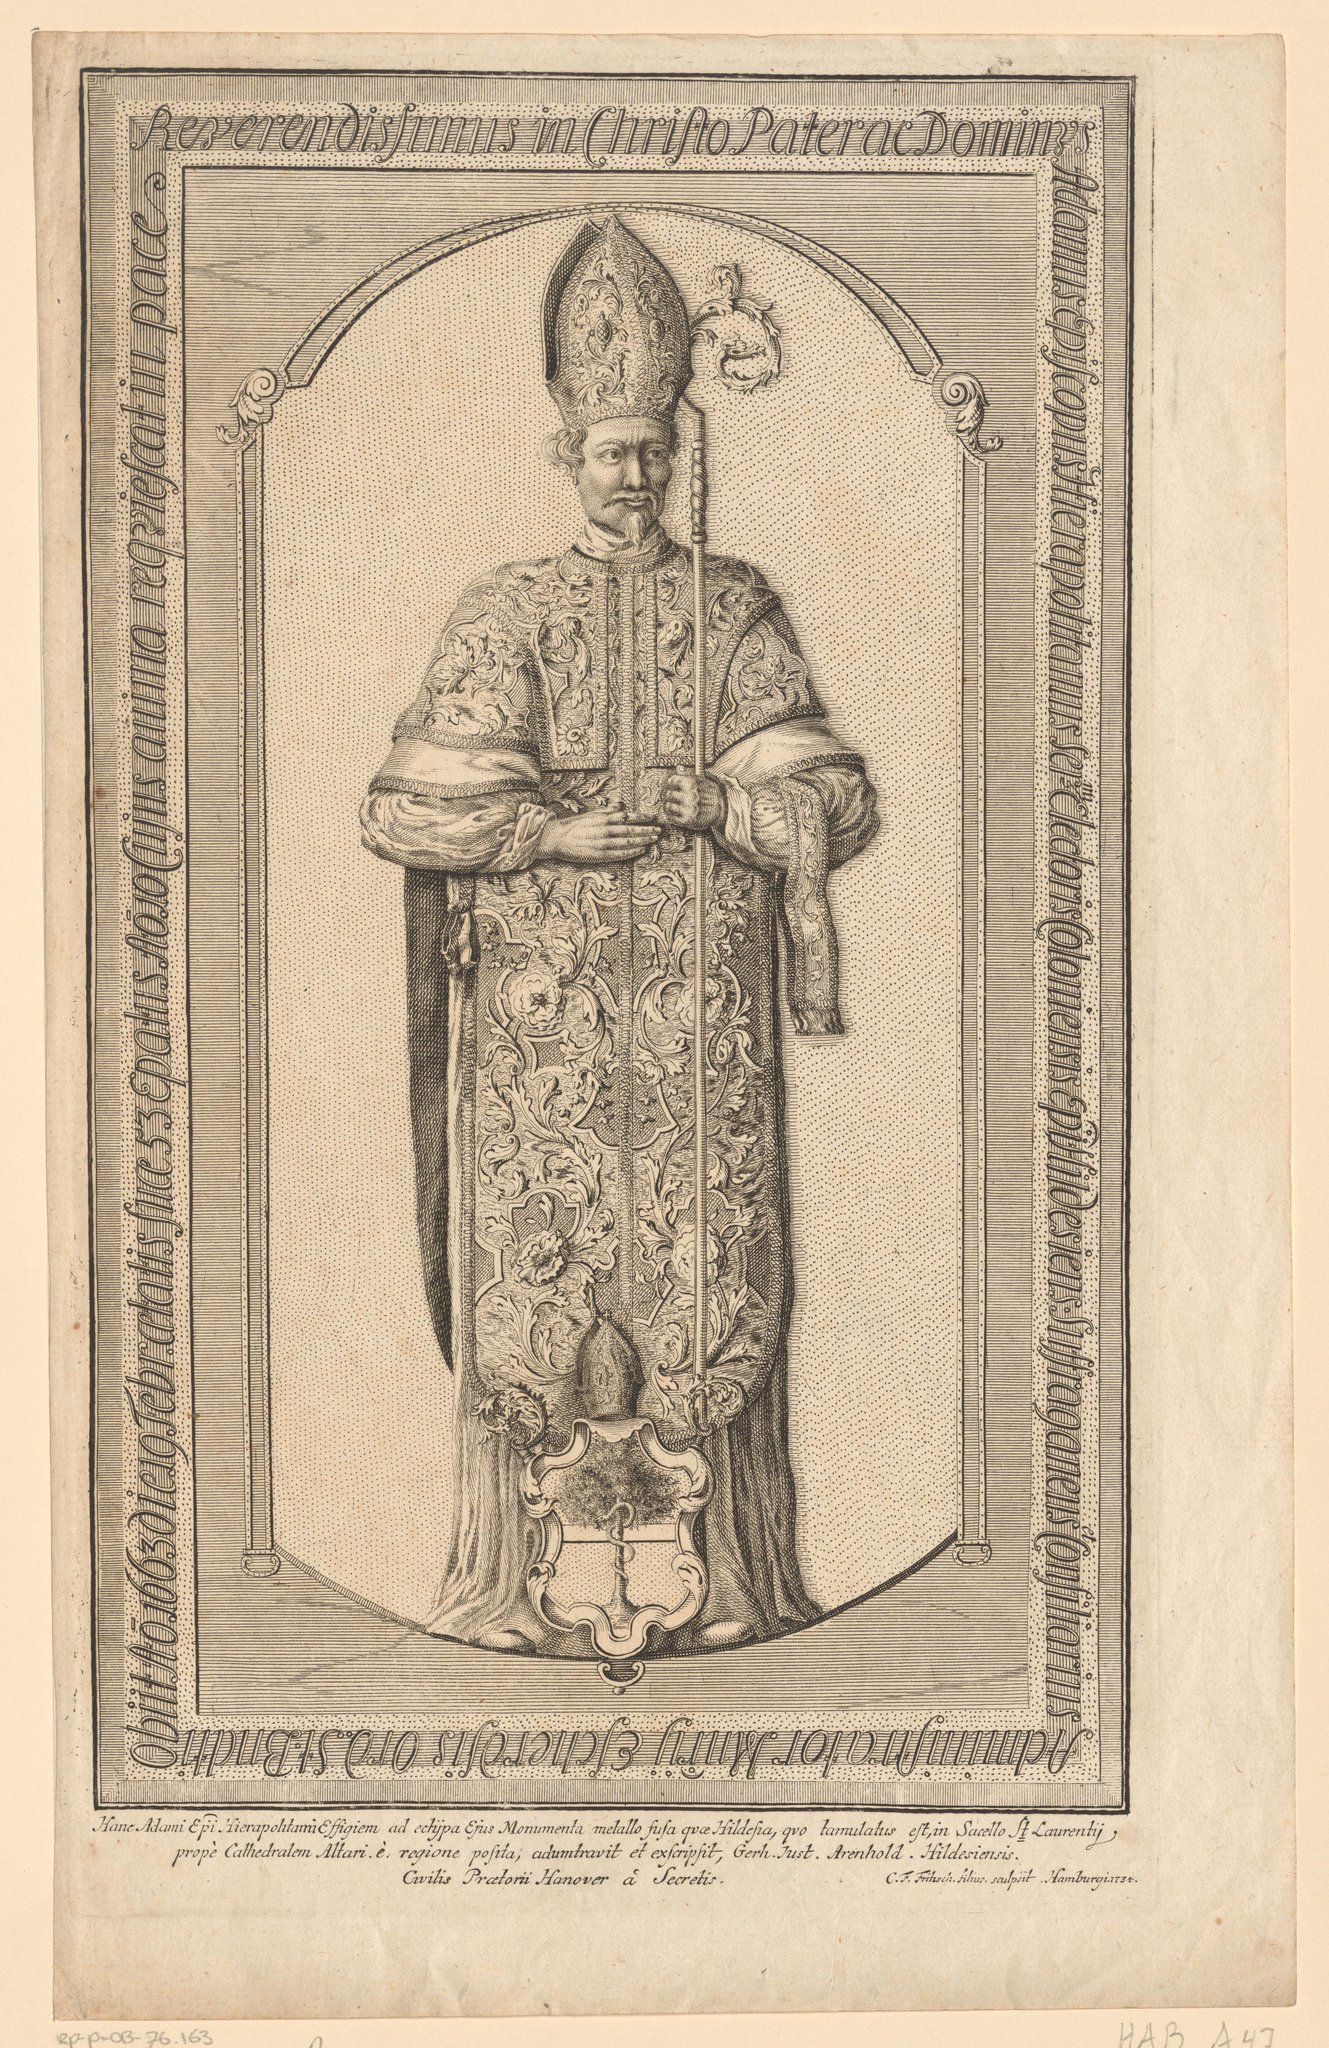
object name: print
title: Portret van Adam Adami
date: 1734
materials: paper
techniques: engraving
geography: hamburg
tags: hildesheim, adam adami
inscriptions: date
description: Portret van Adam Adami in een rechthoekige omlijsting met randschrift. Midden onder een wapen met een slang in een boom en een mijter. In de ondermarge drie regels Latijnse tekst.